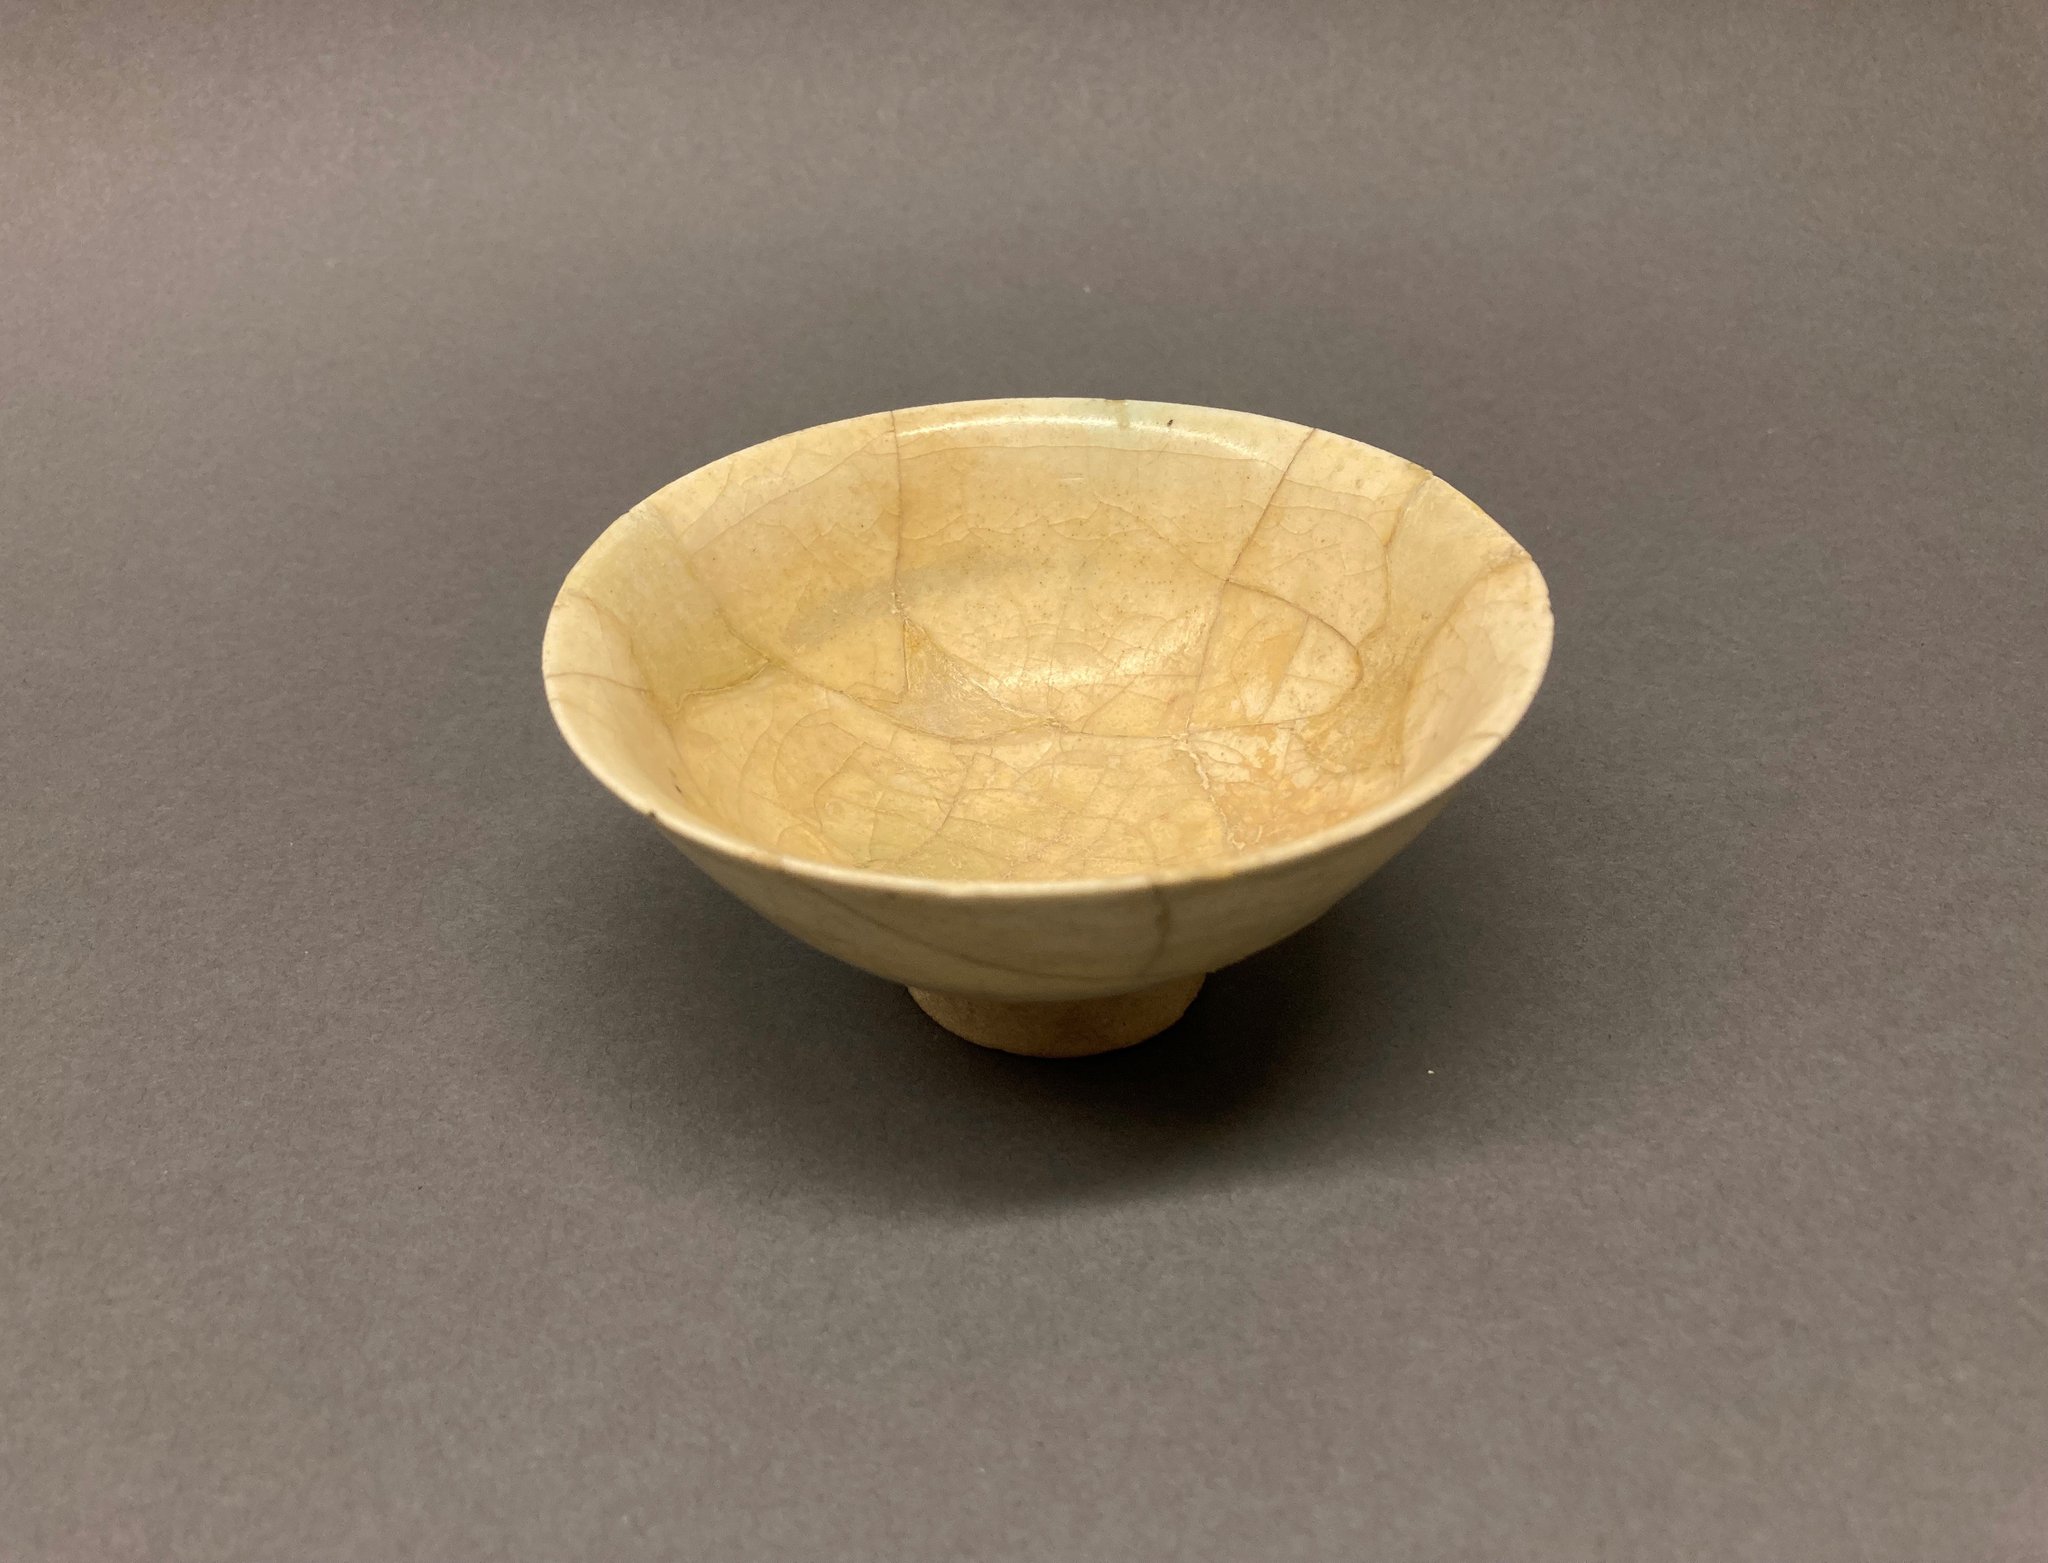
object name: bowl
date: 1001-1100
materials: glaze, stonepaste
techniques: carving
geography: iran